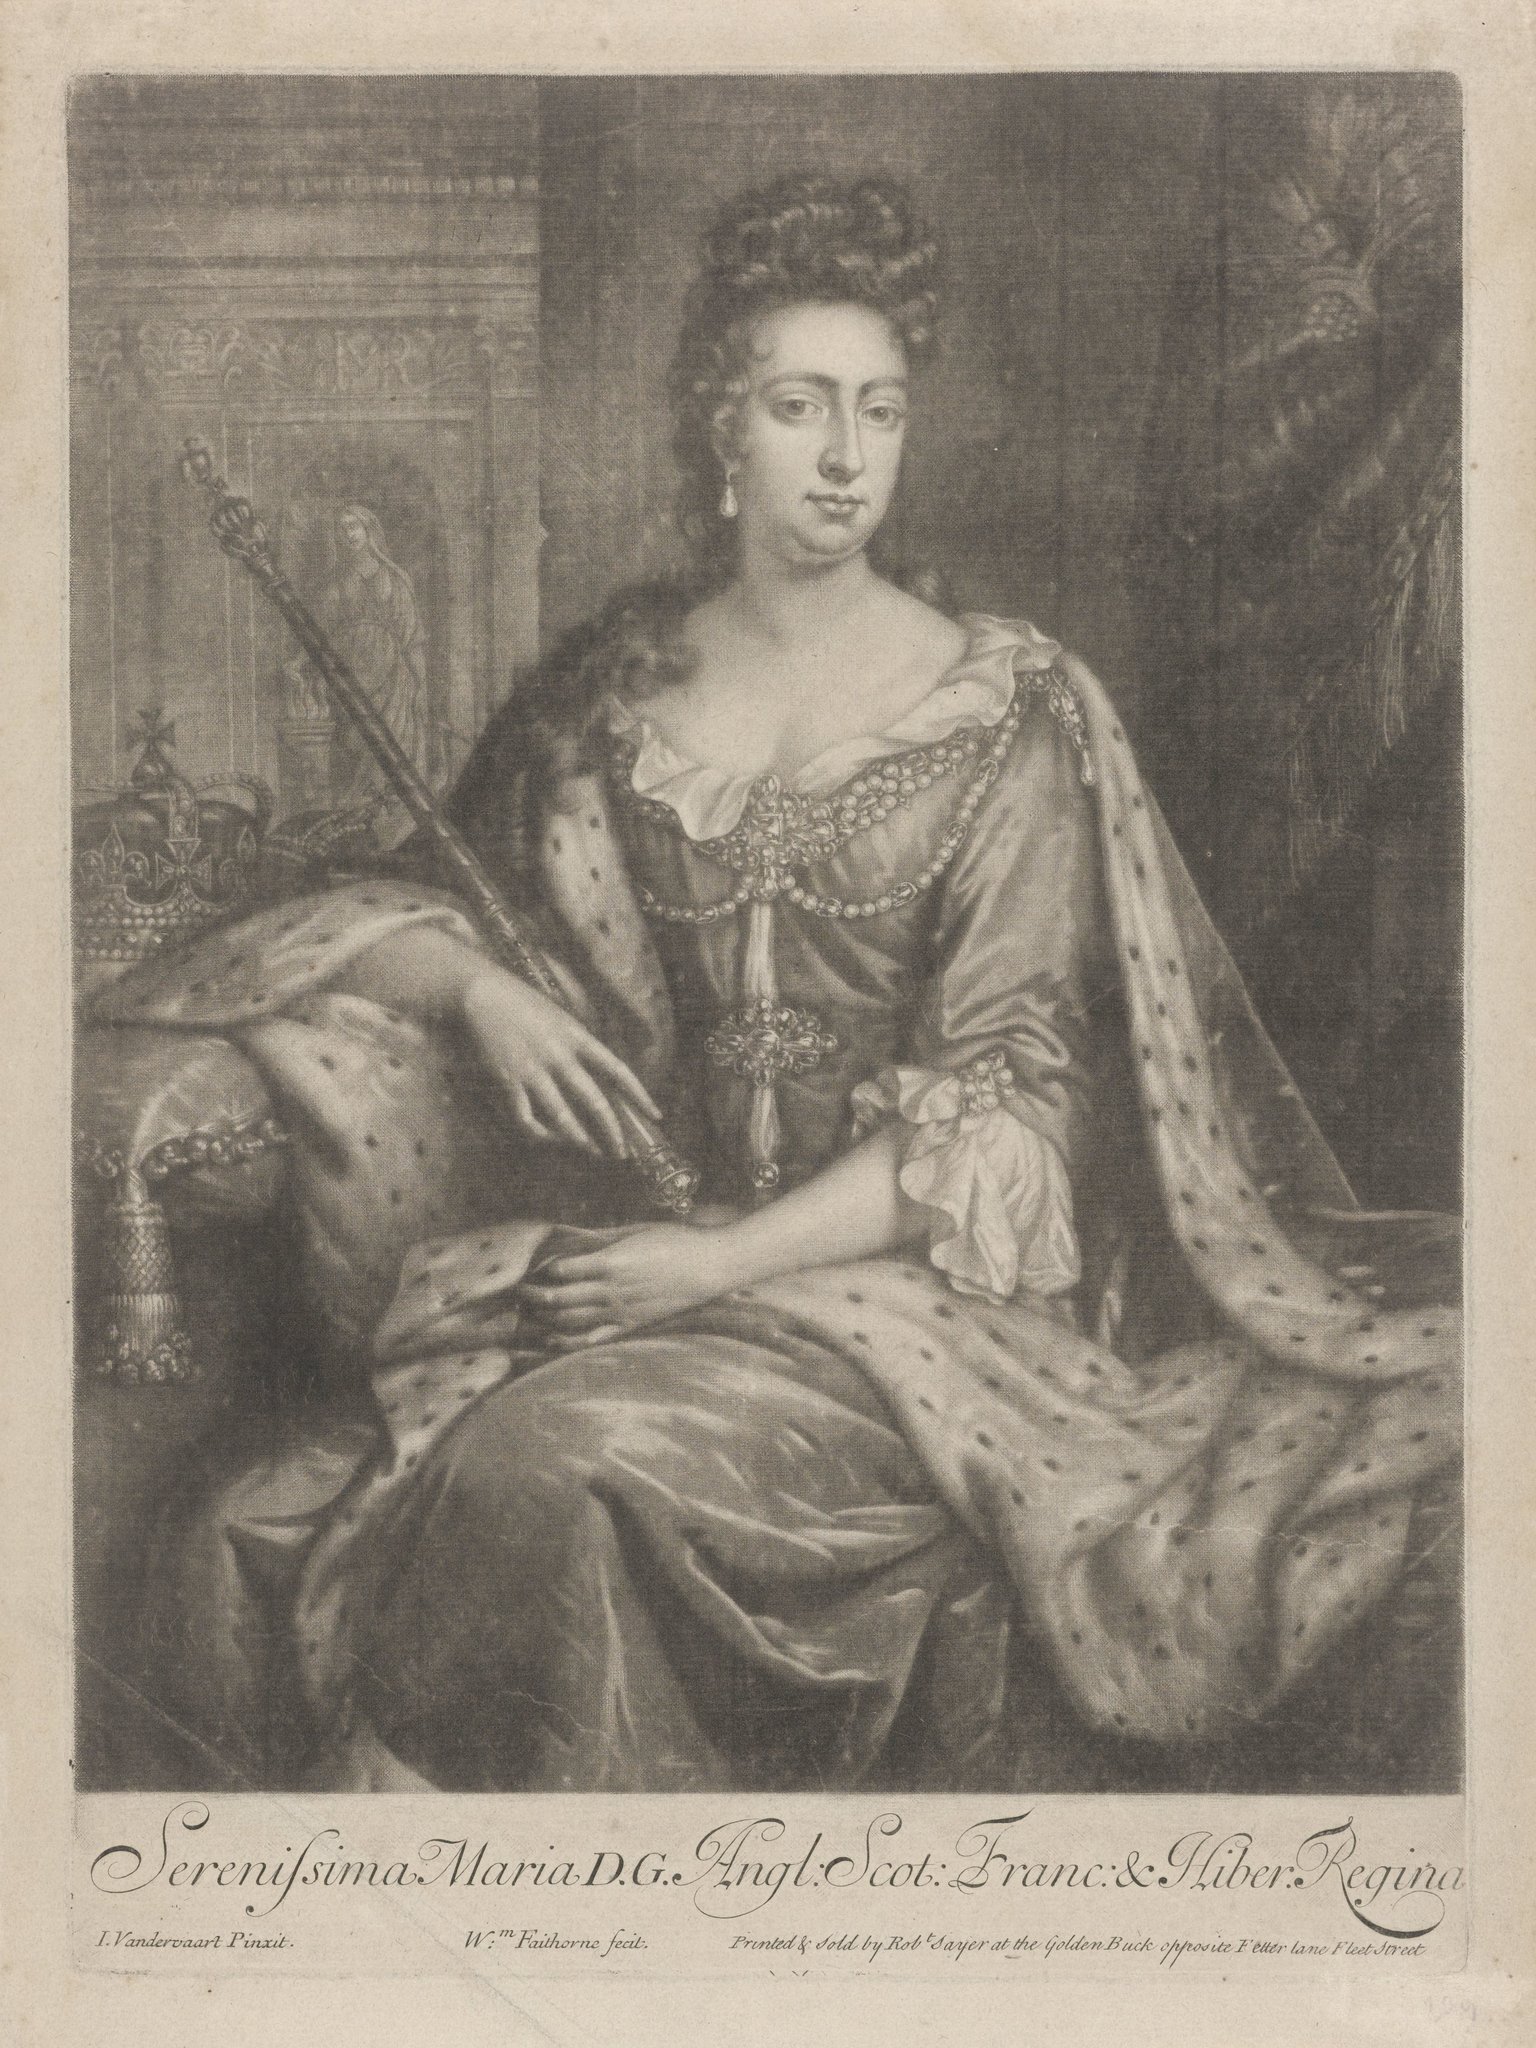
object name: print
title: Portret van Maria II Stuart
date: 1750-1793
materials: paper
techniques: mezzotint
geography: london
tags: london, maria ii stuart (koningin van engeland, schotland en ierland)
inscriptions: collector's mark: Lugt 2228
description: Portret van Maria II. In haar rechterhand een scepter. In de ondermarge haar naam en titels.